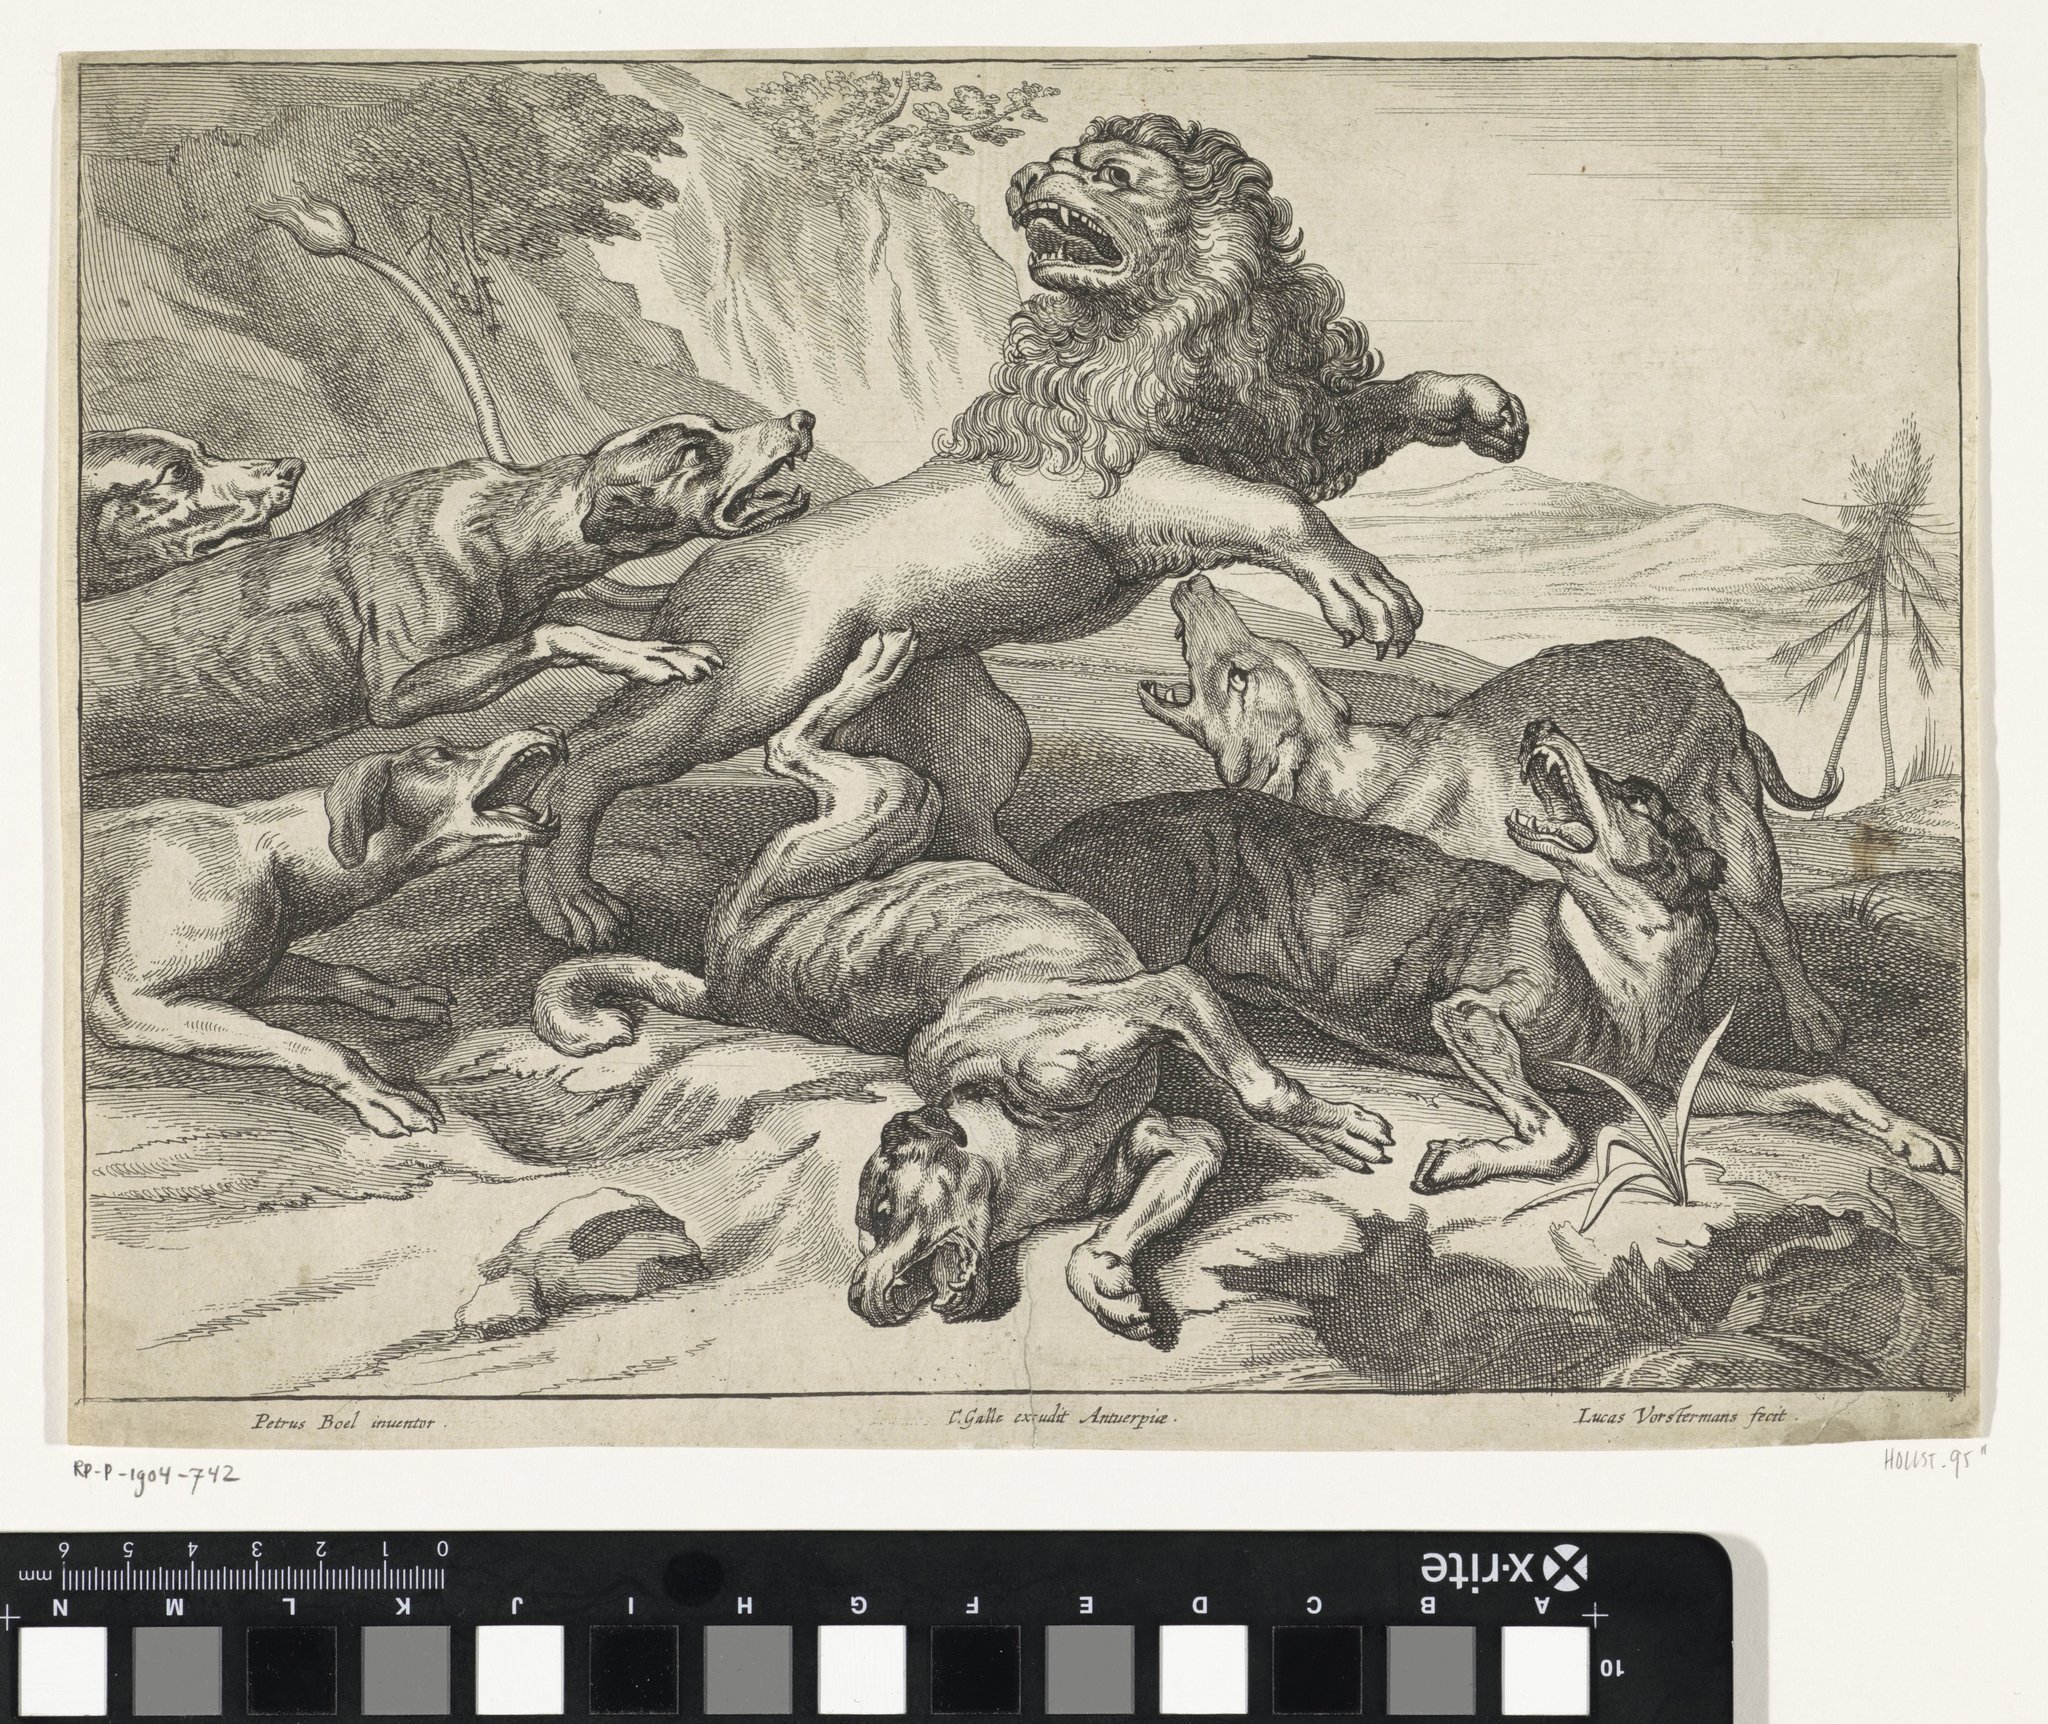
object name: print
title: Honden vallen een leeuw aan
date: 1651-1676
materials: paper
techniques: etching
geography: antwerp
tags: hunting dogs, beasts of prey, predatory animals: lion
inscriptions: collector's mark: Lugt 2228